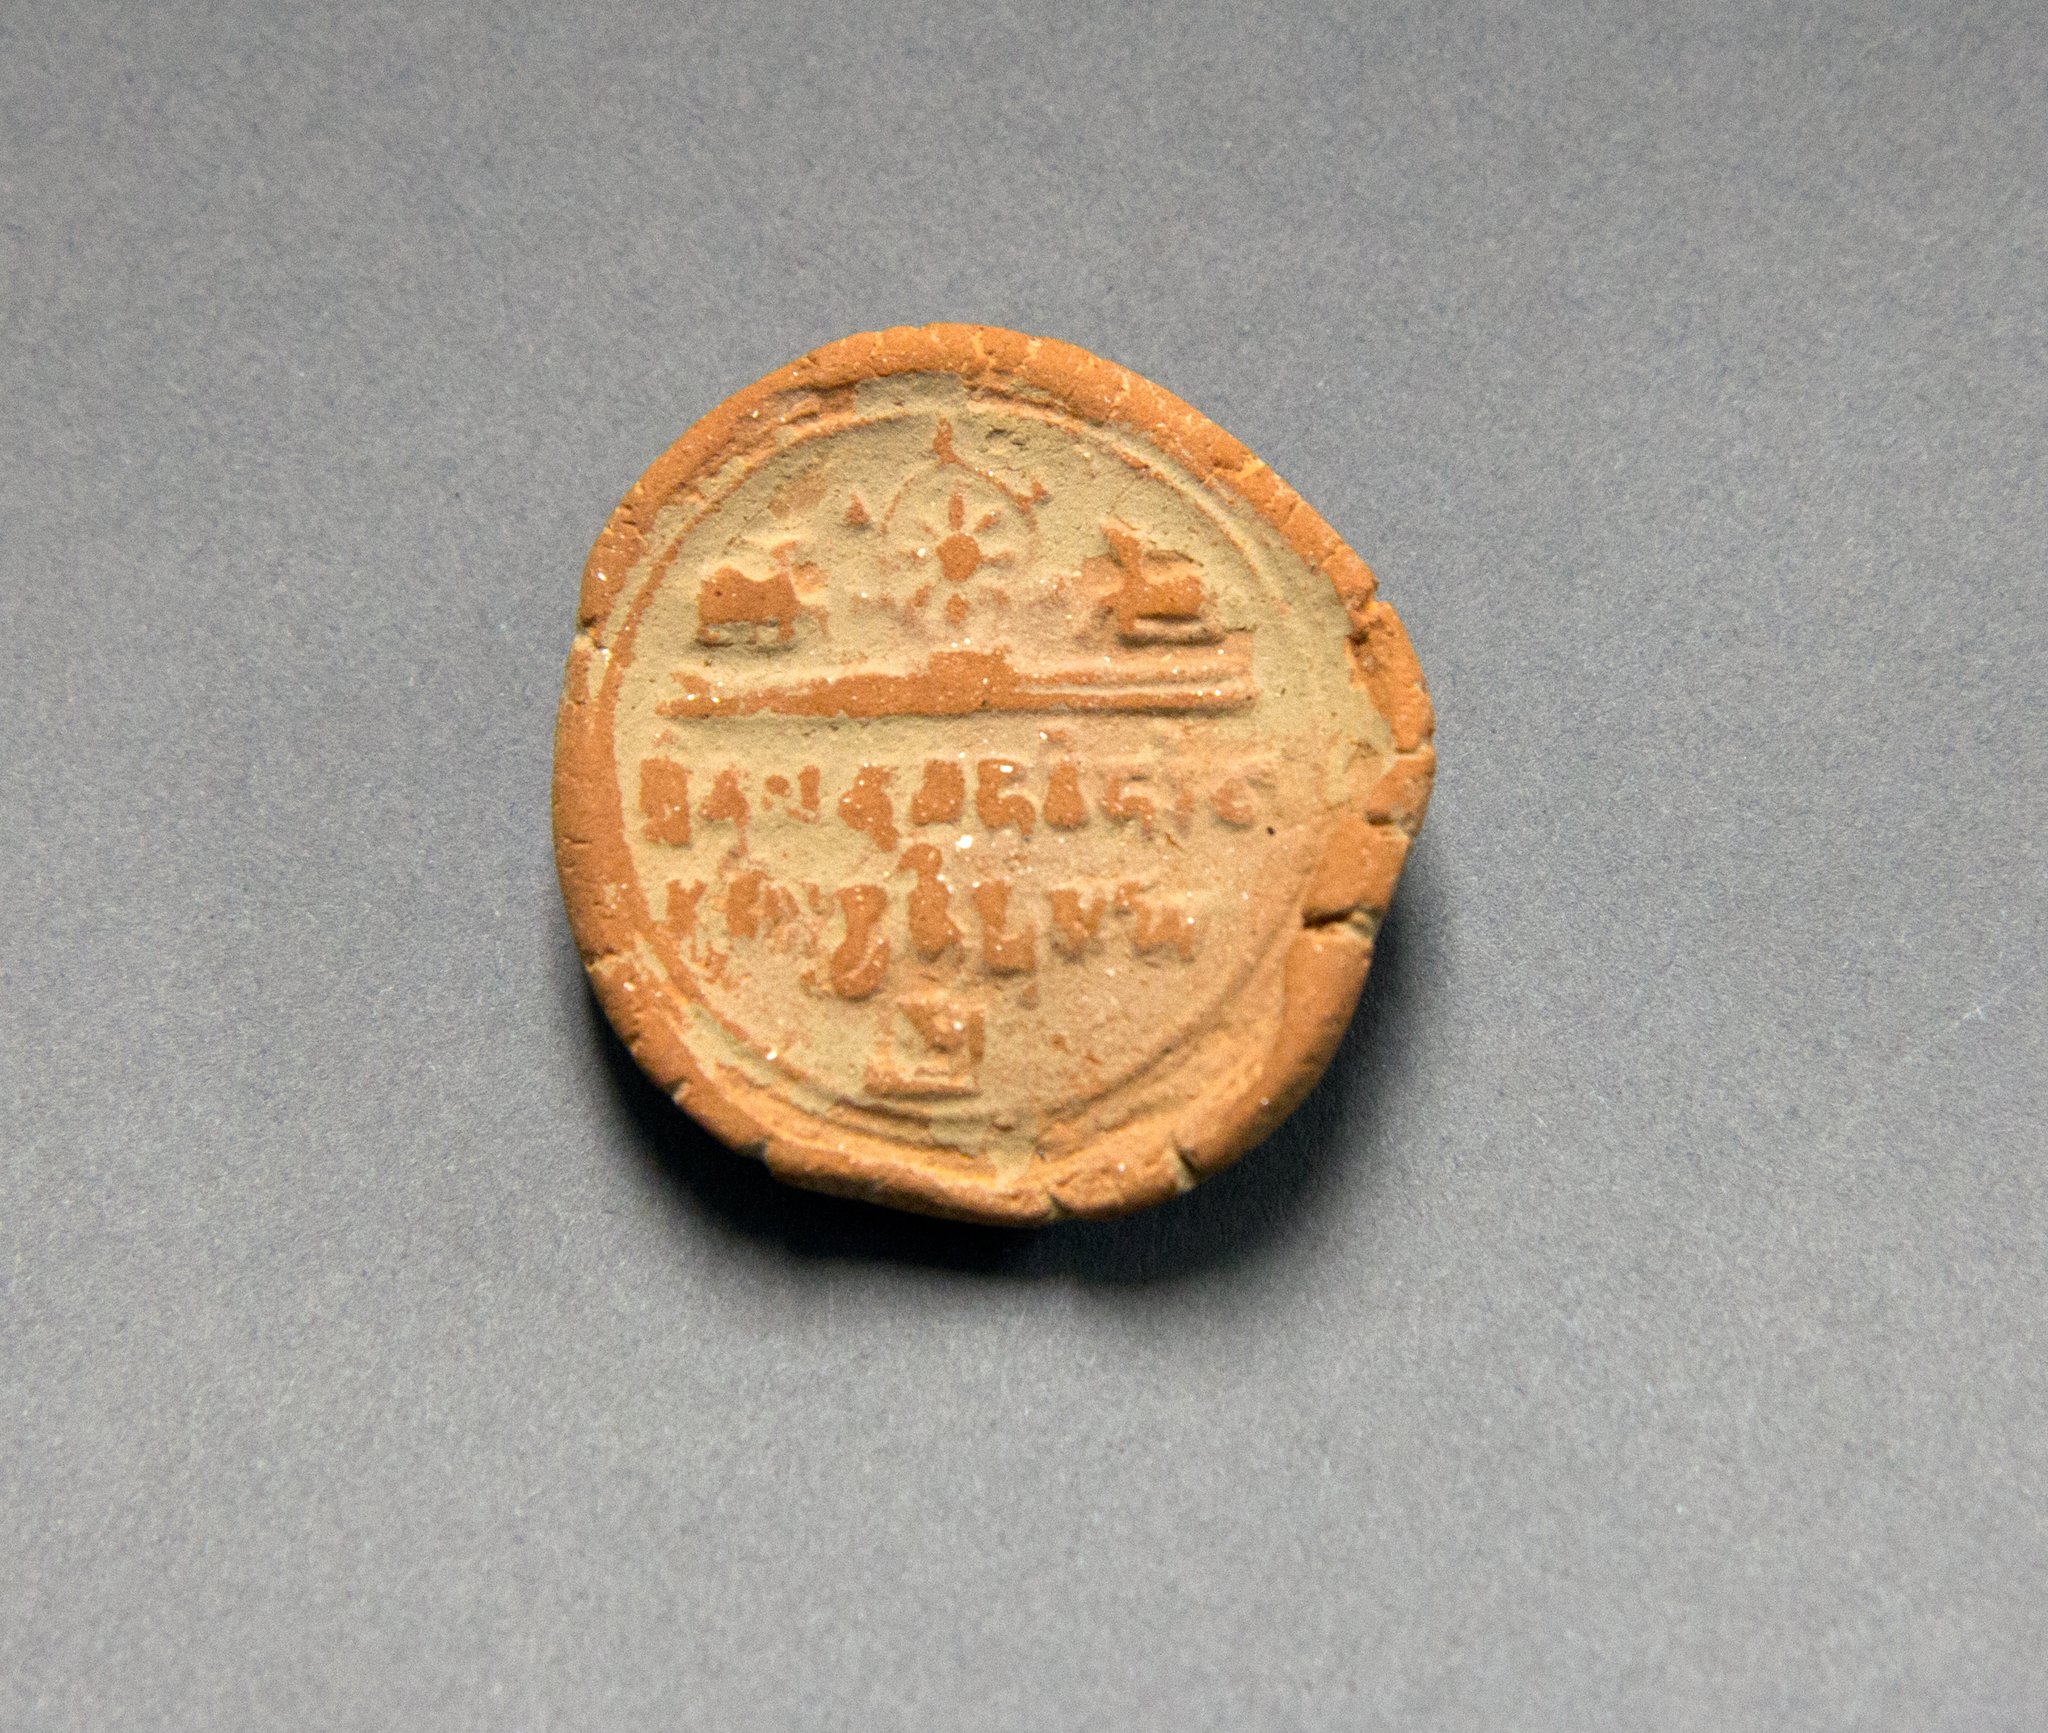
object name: seal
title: Round Seal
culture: indian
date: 501-600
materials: terracotta